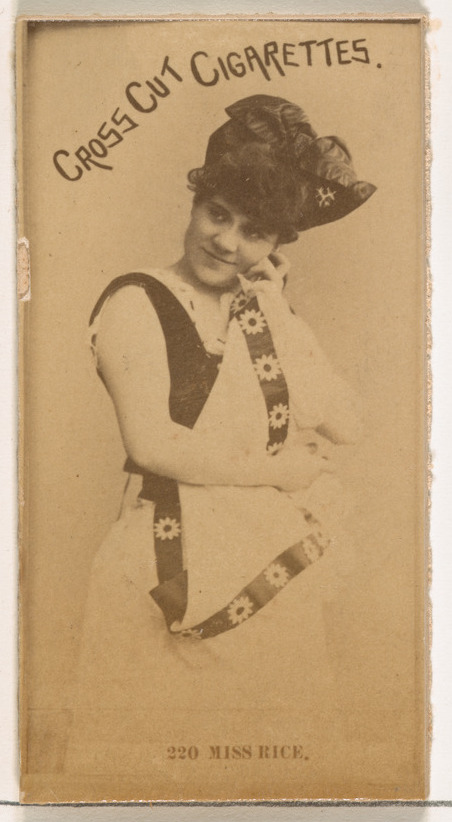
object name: print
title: Card Number 220, Fanny Rice, from the Actors and Actresses series (N145-2) issued by Duke Sons & Co. to promote Cross Cut Cigarettes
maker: w. duke, sons & co.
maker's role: publisher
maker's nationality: american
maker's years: 1870-1920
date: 1880-1889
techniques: albumen silver print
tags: portraits,women,actresses